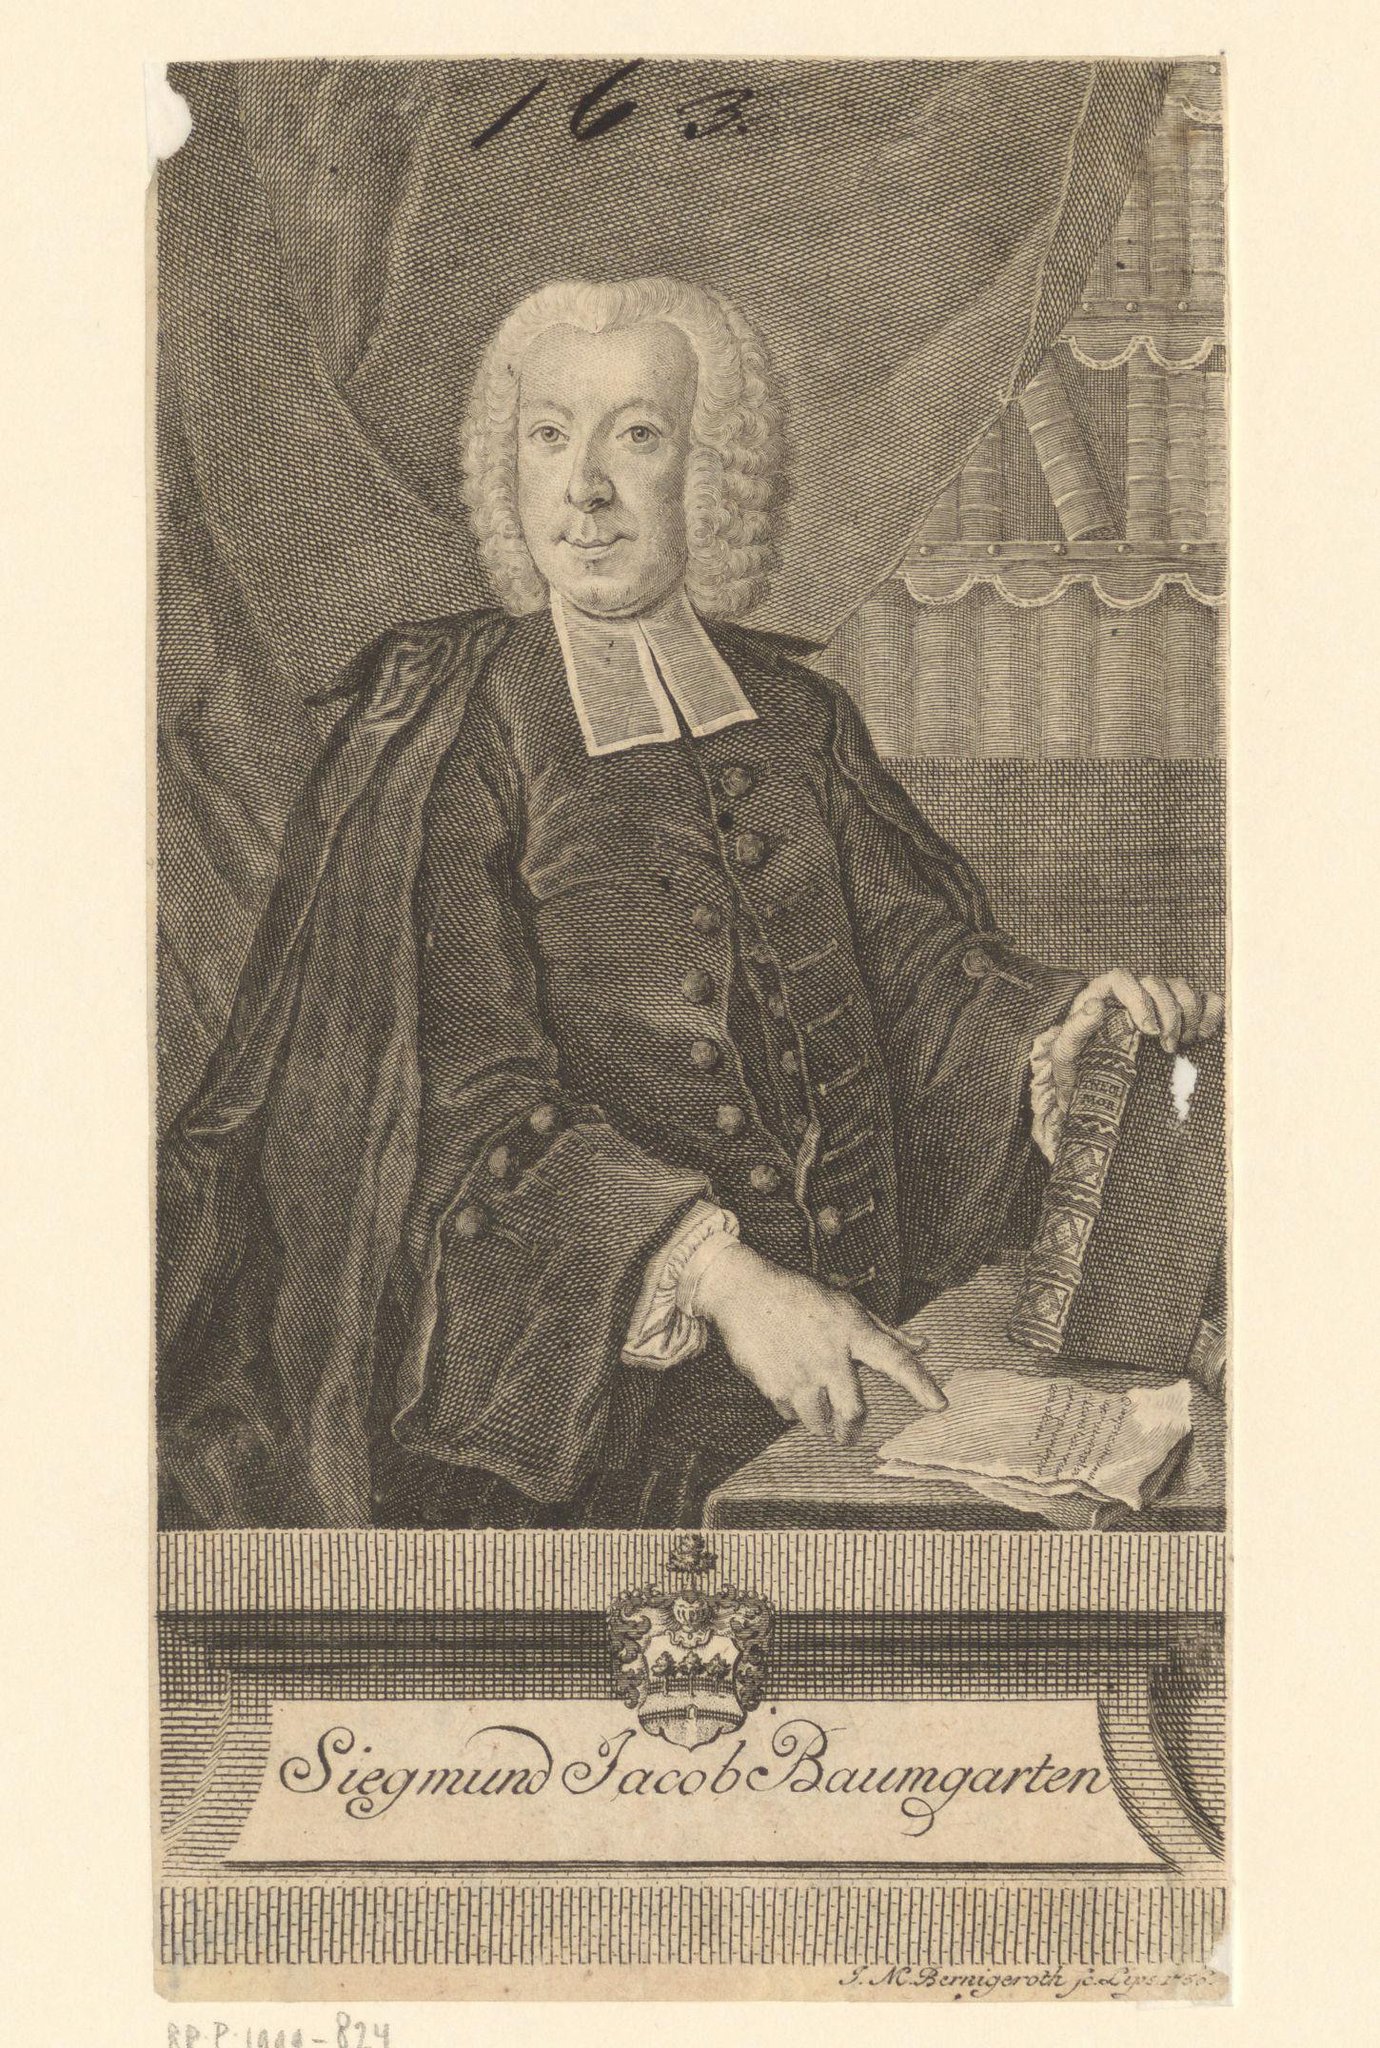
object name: print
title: Portret van Sigmund Jacob Baumgarten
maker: johann martin bernigeroth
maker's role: print maker, publisher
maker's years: 1713-1767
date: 1756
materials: paper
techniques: engraving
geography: leipzig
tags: bookshelves, historical persons, book, armorial bearing, heraldry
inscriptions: collector's mark: Lugt 2228, collector's mark: Lugt 2760